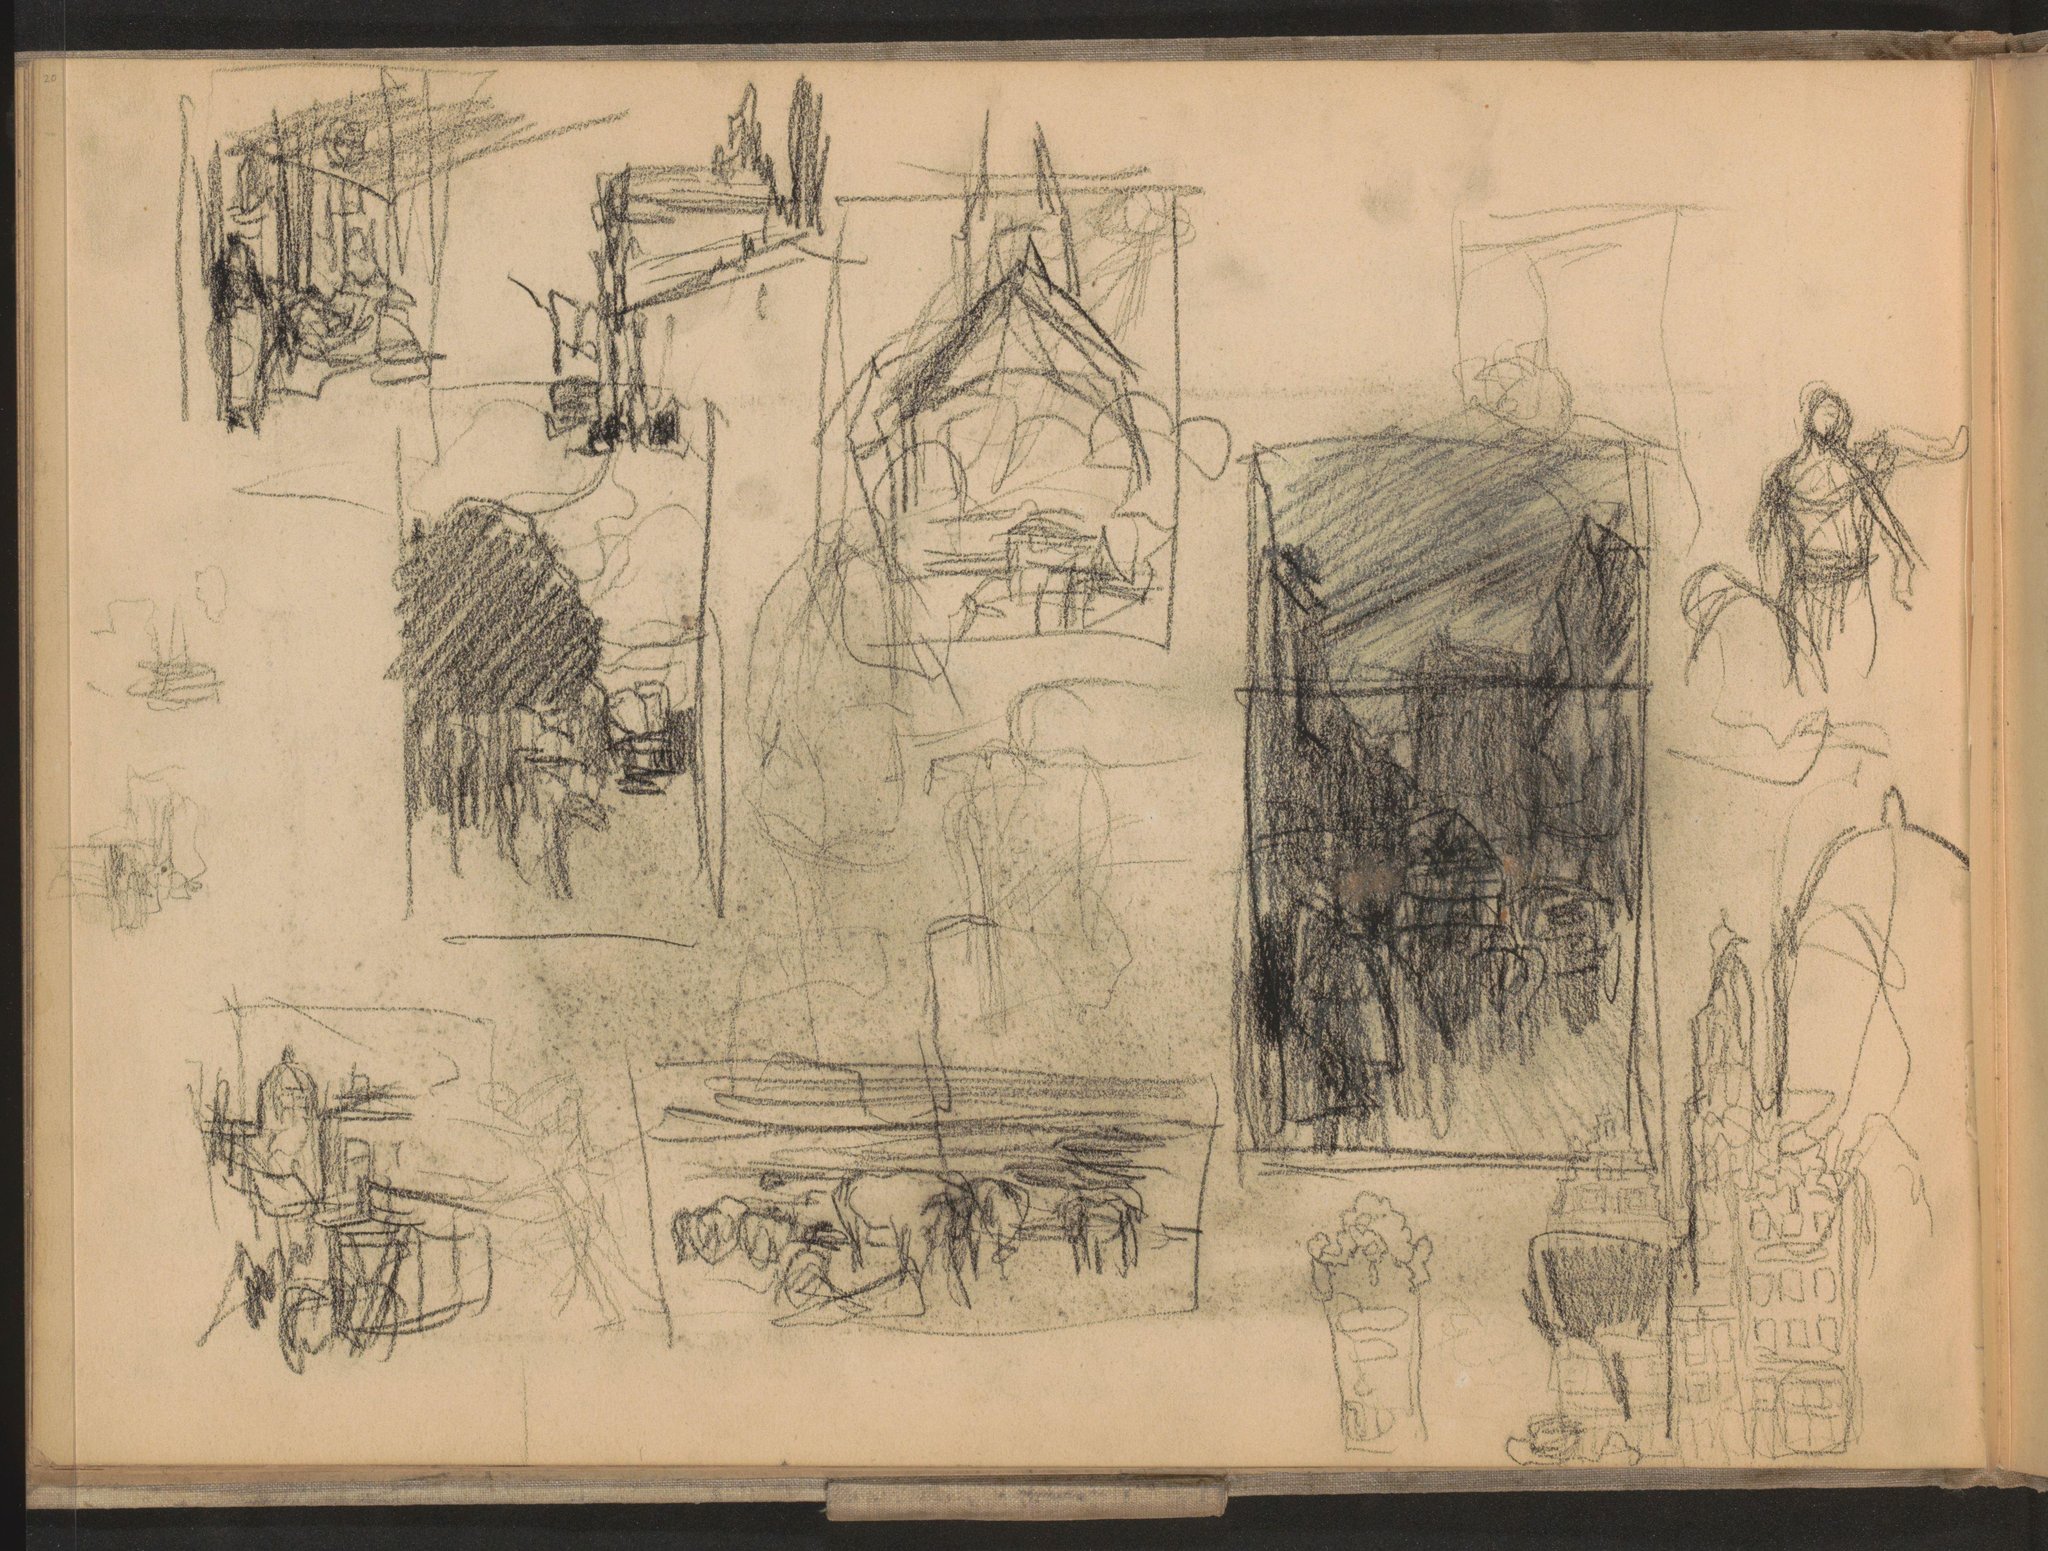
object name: sketchbook leaf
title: Straatgezichten en een figuurstudie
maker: marius bauer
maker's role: draughtsman, print maker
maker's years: 1867-1932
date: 1887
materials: chalk, paper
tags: urban housing, anatomy (non-medical), street (+ city(-scape) with figures, staffage)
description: Pagina 20 uit een schetsboek met 19 bladen.